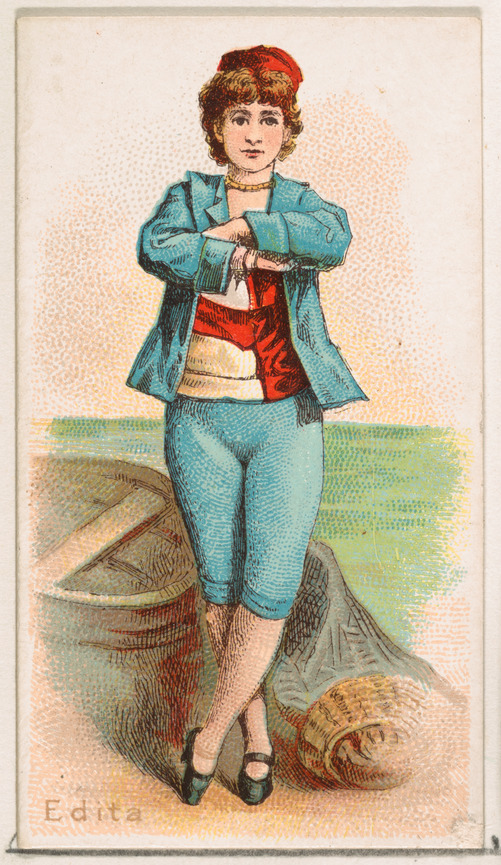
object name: print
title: Edita, from the Ballet Queens series (N182) issued by Wm. S. Kimball & Co.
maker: william s. kimball & company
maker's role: publisher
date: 1889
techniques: color lithograph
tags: women,dancers